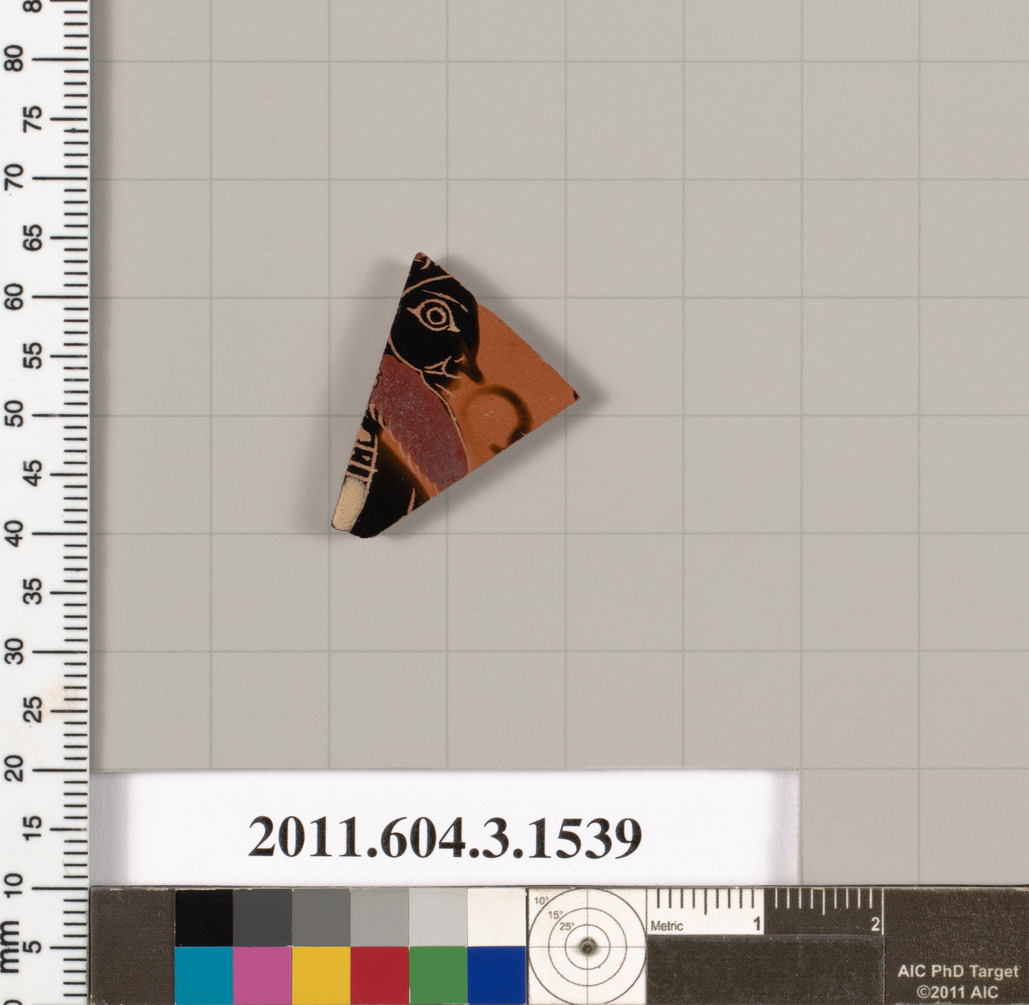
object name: kylix fragment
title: Terracotta fragment of a kylix (drinking cup)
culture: greek, attic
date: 550-526 BCE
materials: terracotta